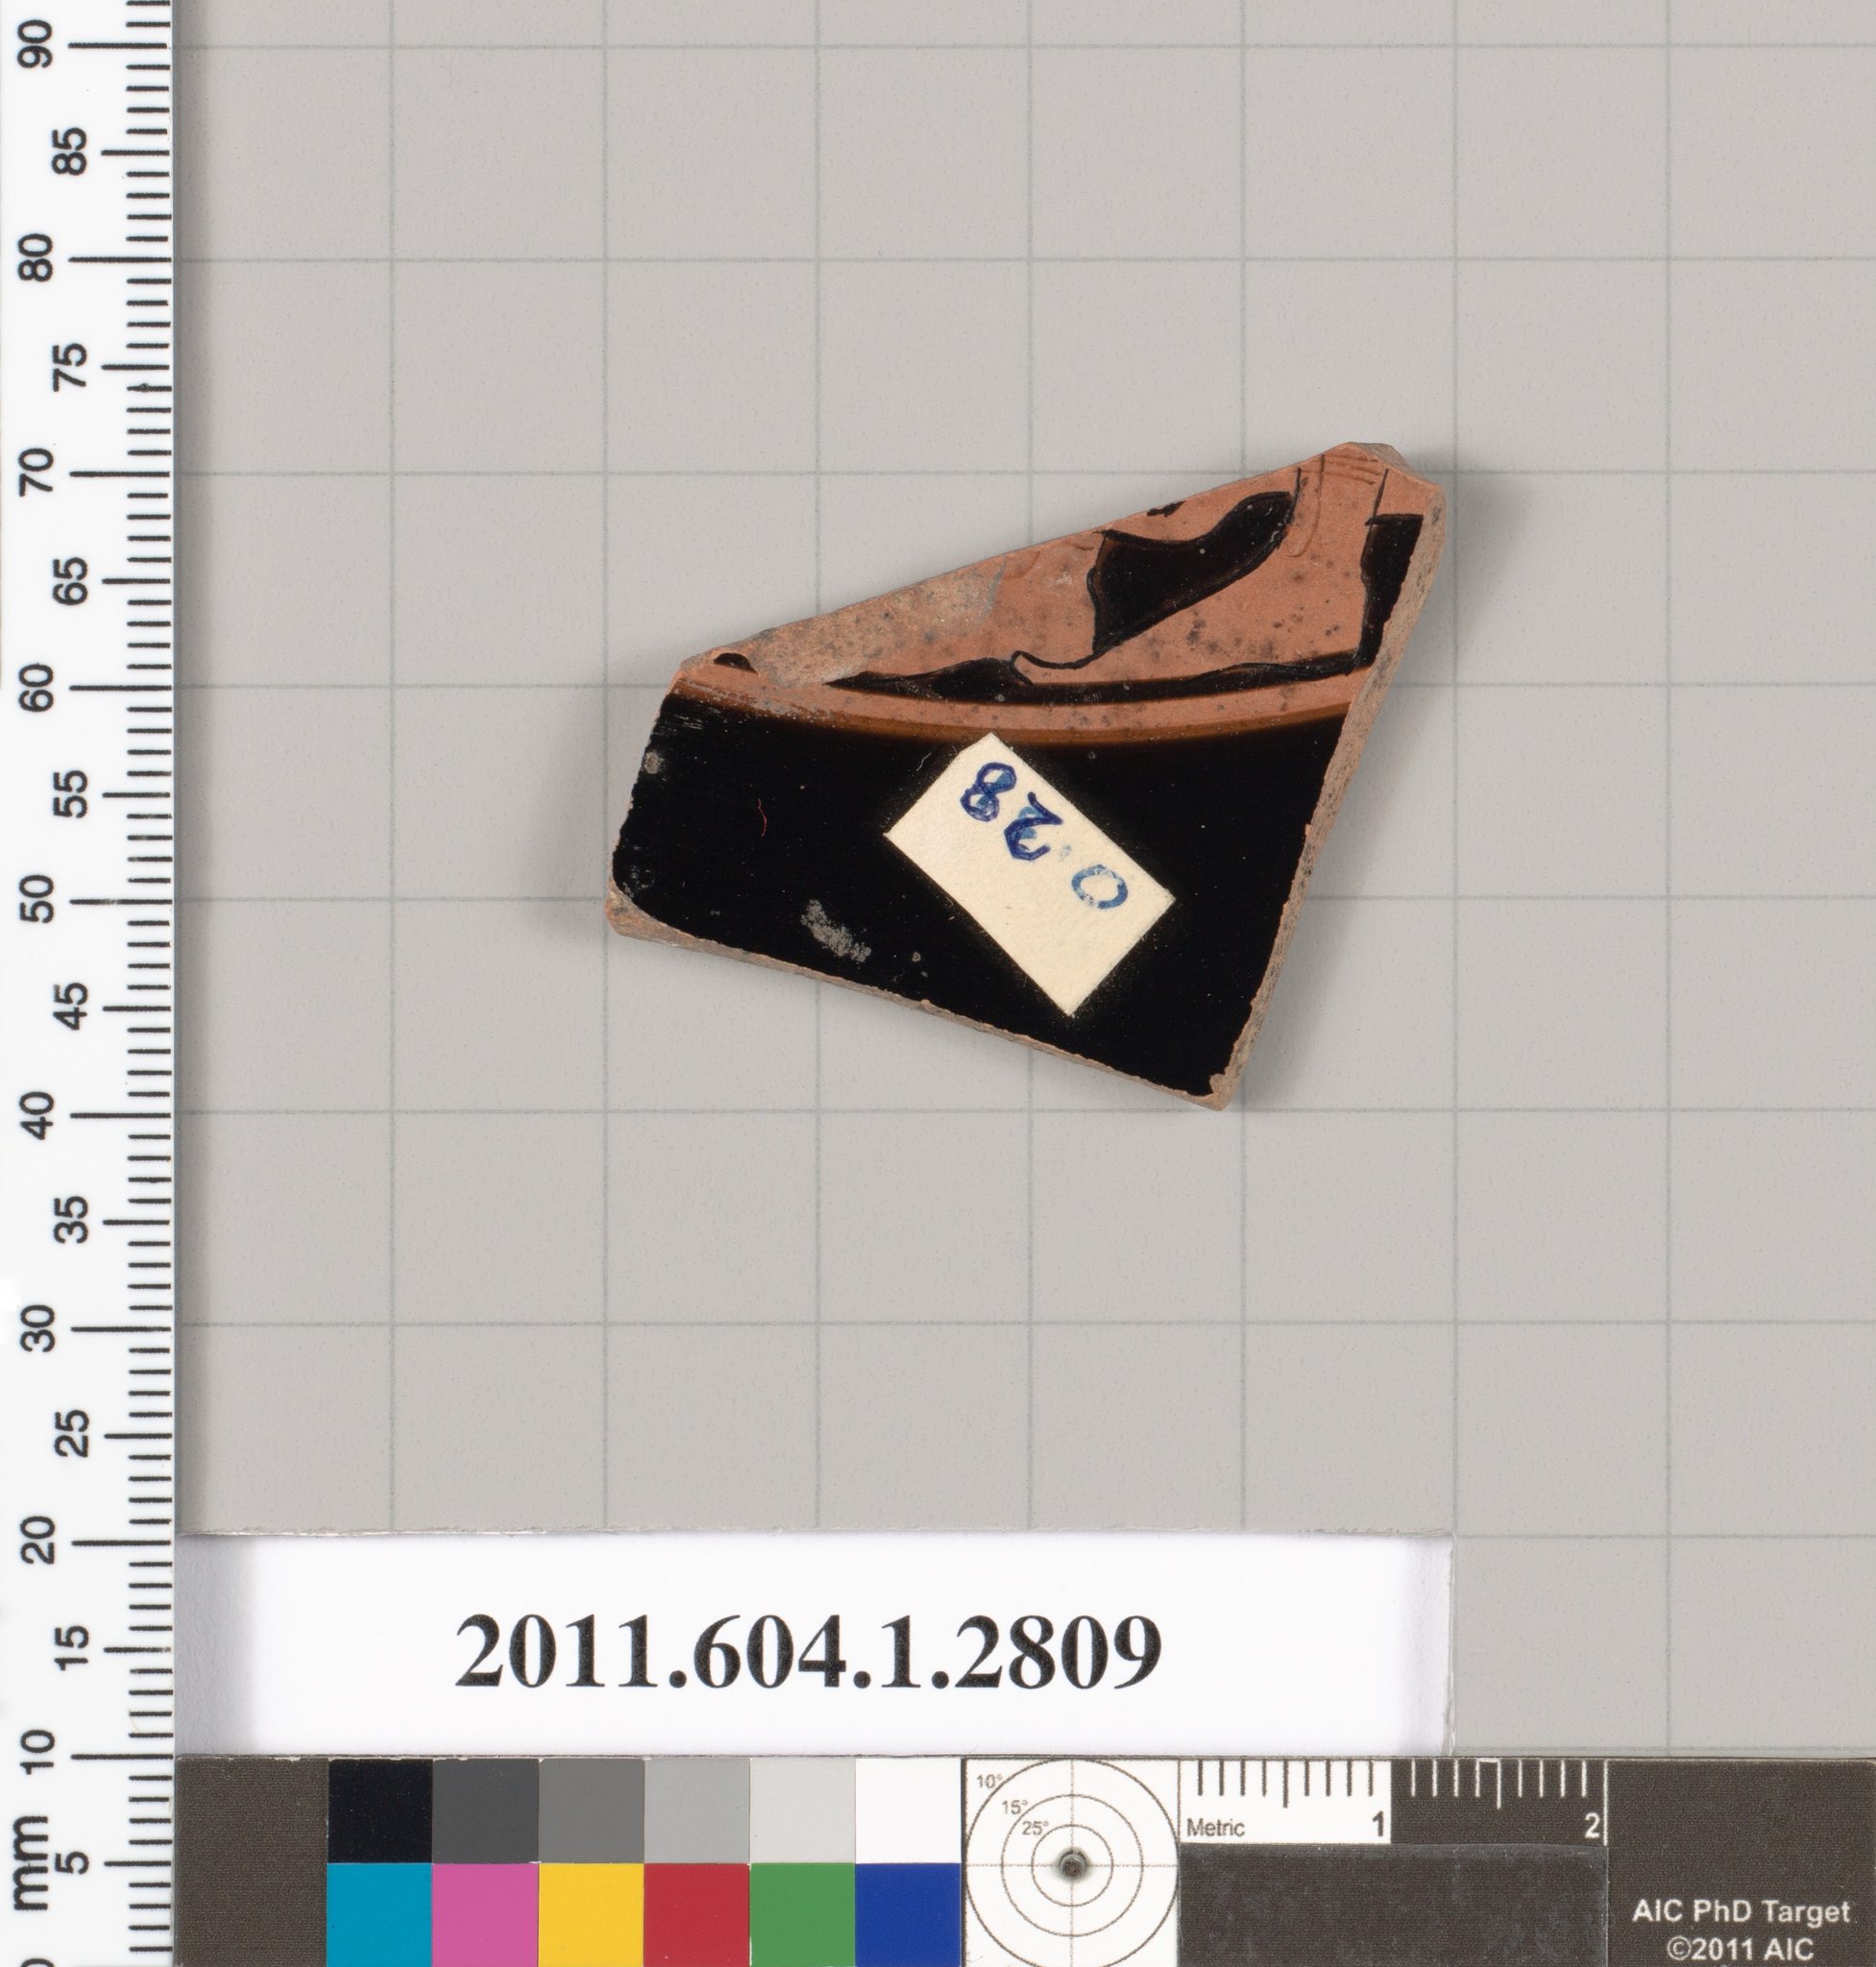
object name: kylix fragment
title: Terracotta fragment of a kylix (drinking cup)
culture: greek, attic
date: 520-500 BCE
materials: terracotta